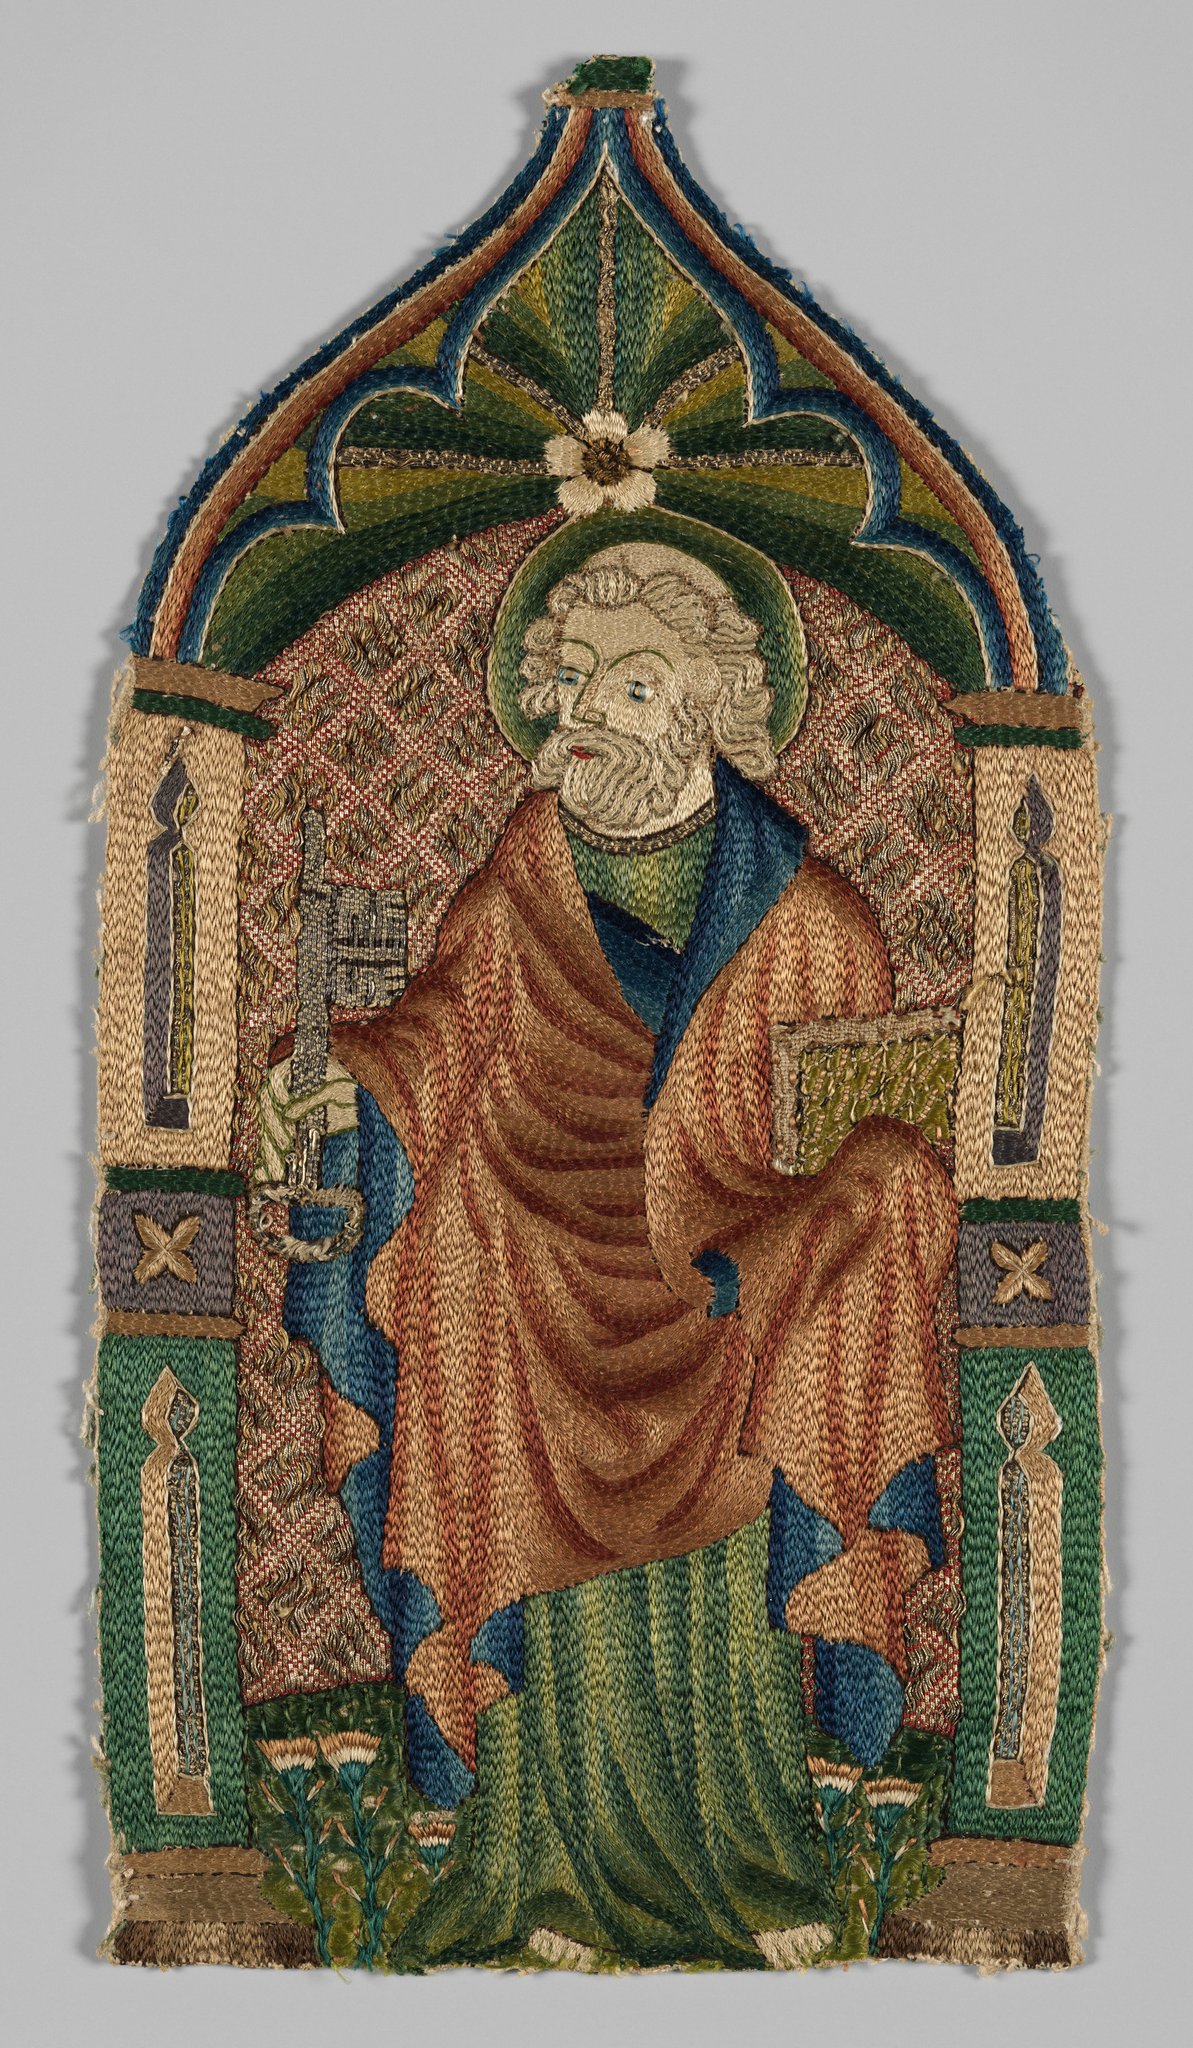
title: Four Embroidered Saints, probably from an Orphrey: St. Peter, St. Catherine, St. Thomas, and St. Barbara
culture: british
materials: linen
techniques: embroidery